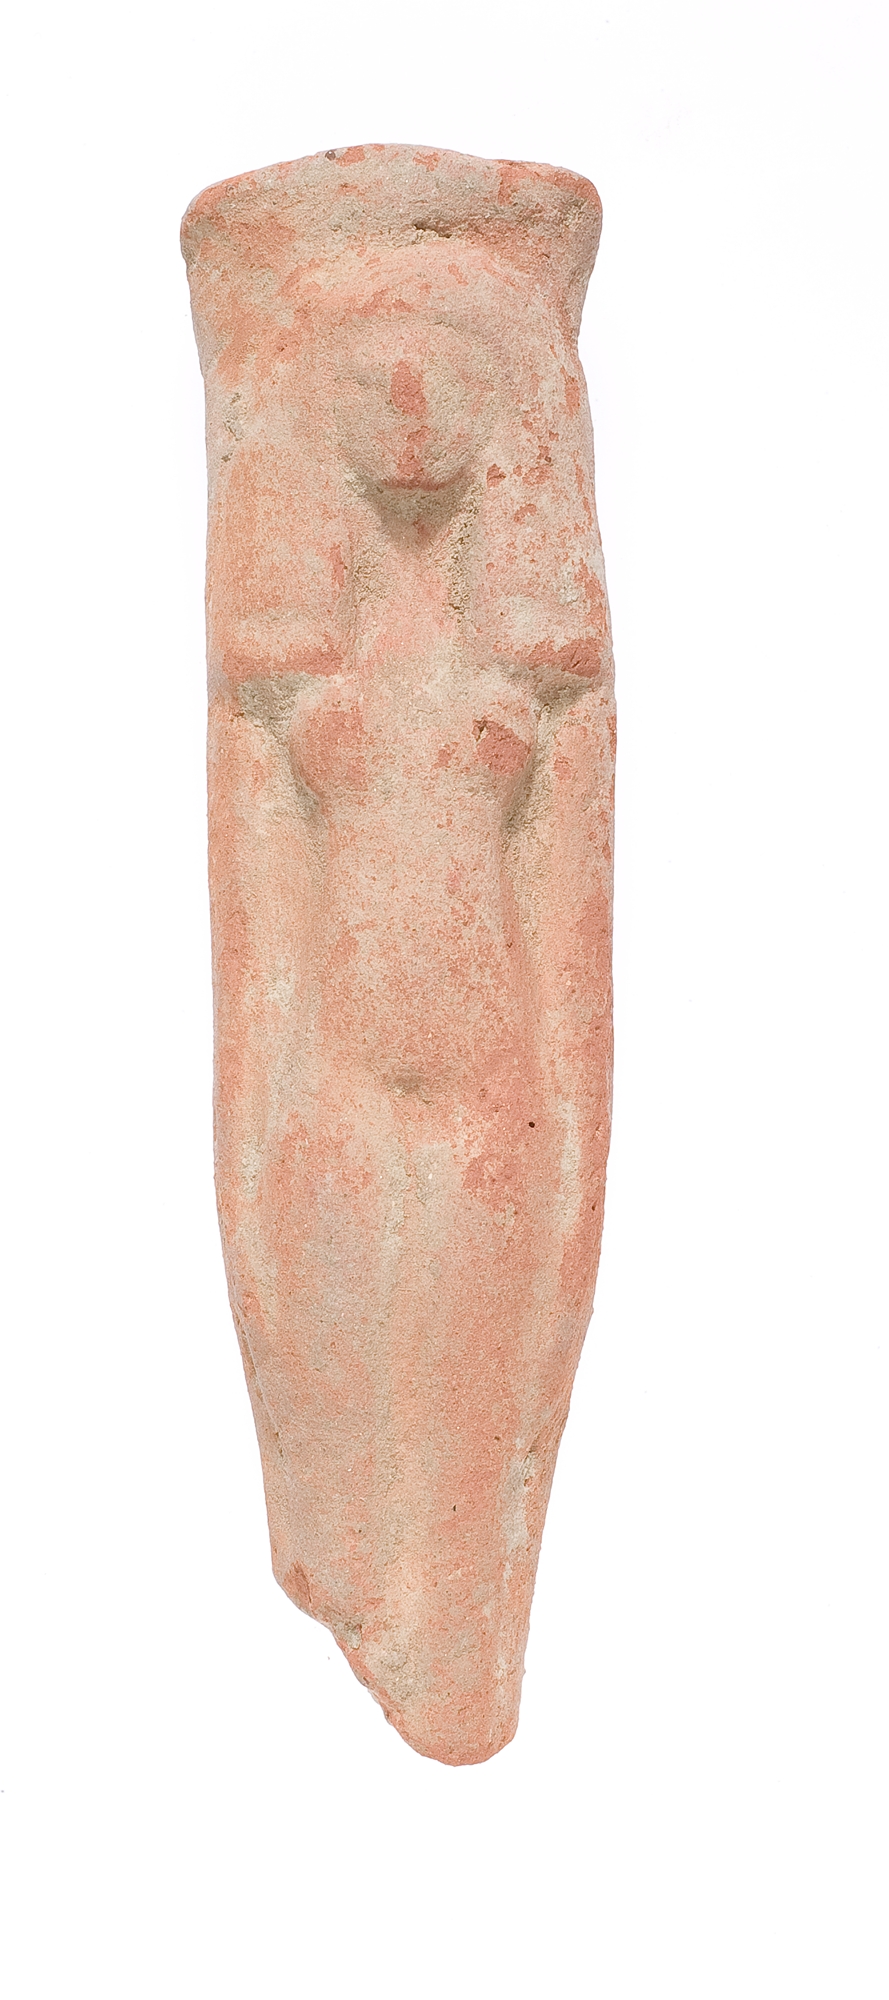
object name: statuette of a woman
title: Standing female figurine with missing legs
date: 1390-1186 BCE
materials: pottery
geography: egypt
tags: women